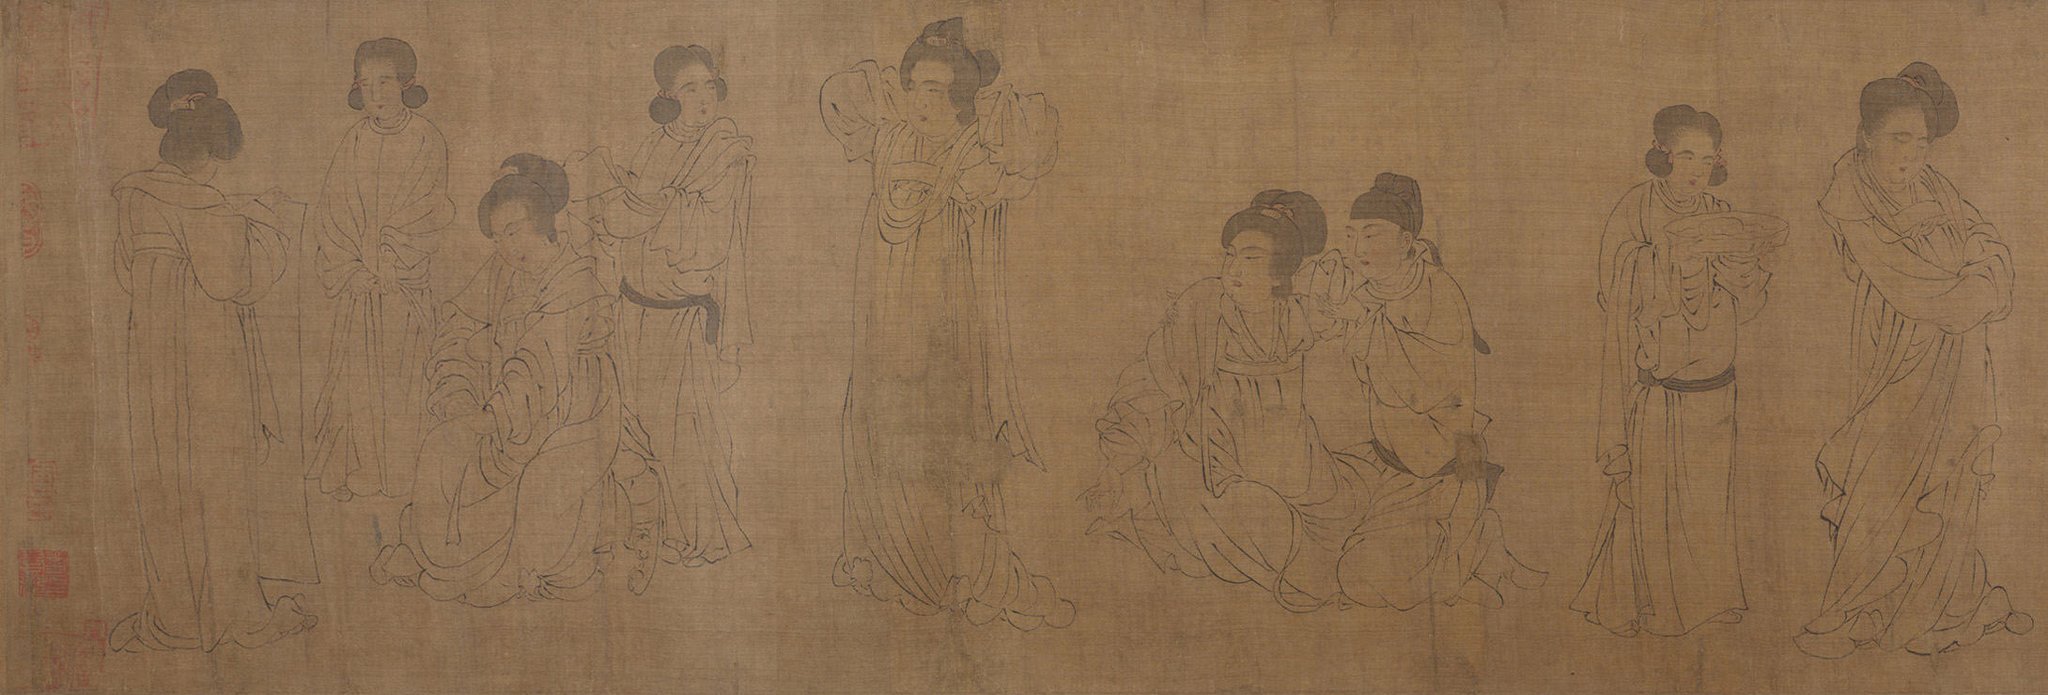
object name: handscroll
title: In the Palace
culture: chinese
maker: unidentified artist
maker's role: artist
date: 1140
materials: ink, silk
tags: women